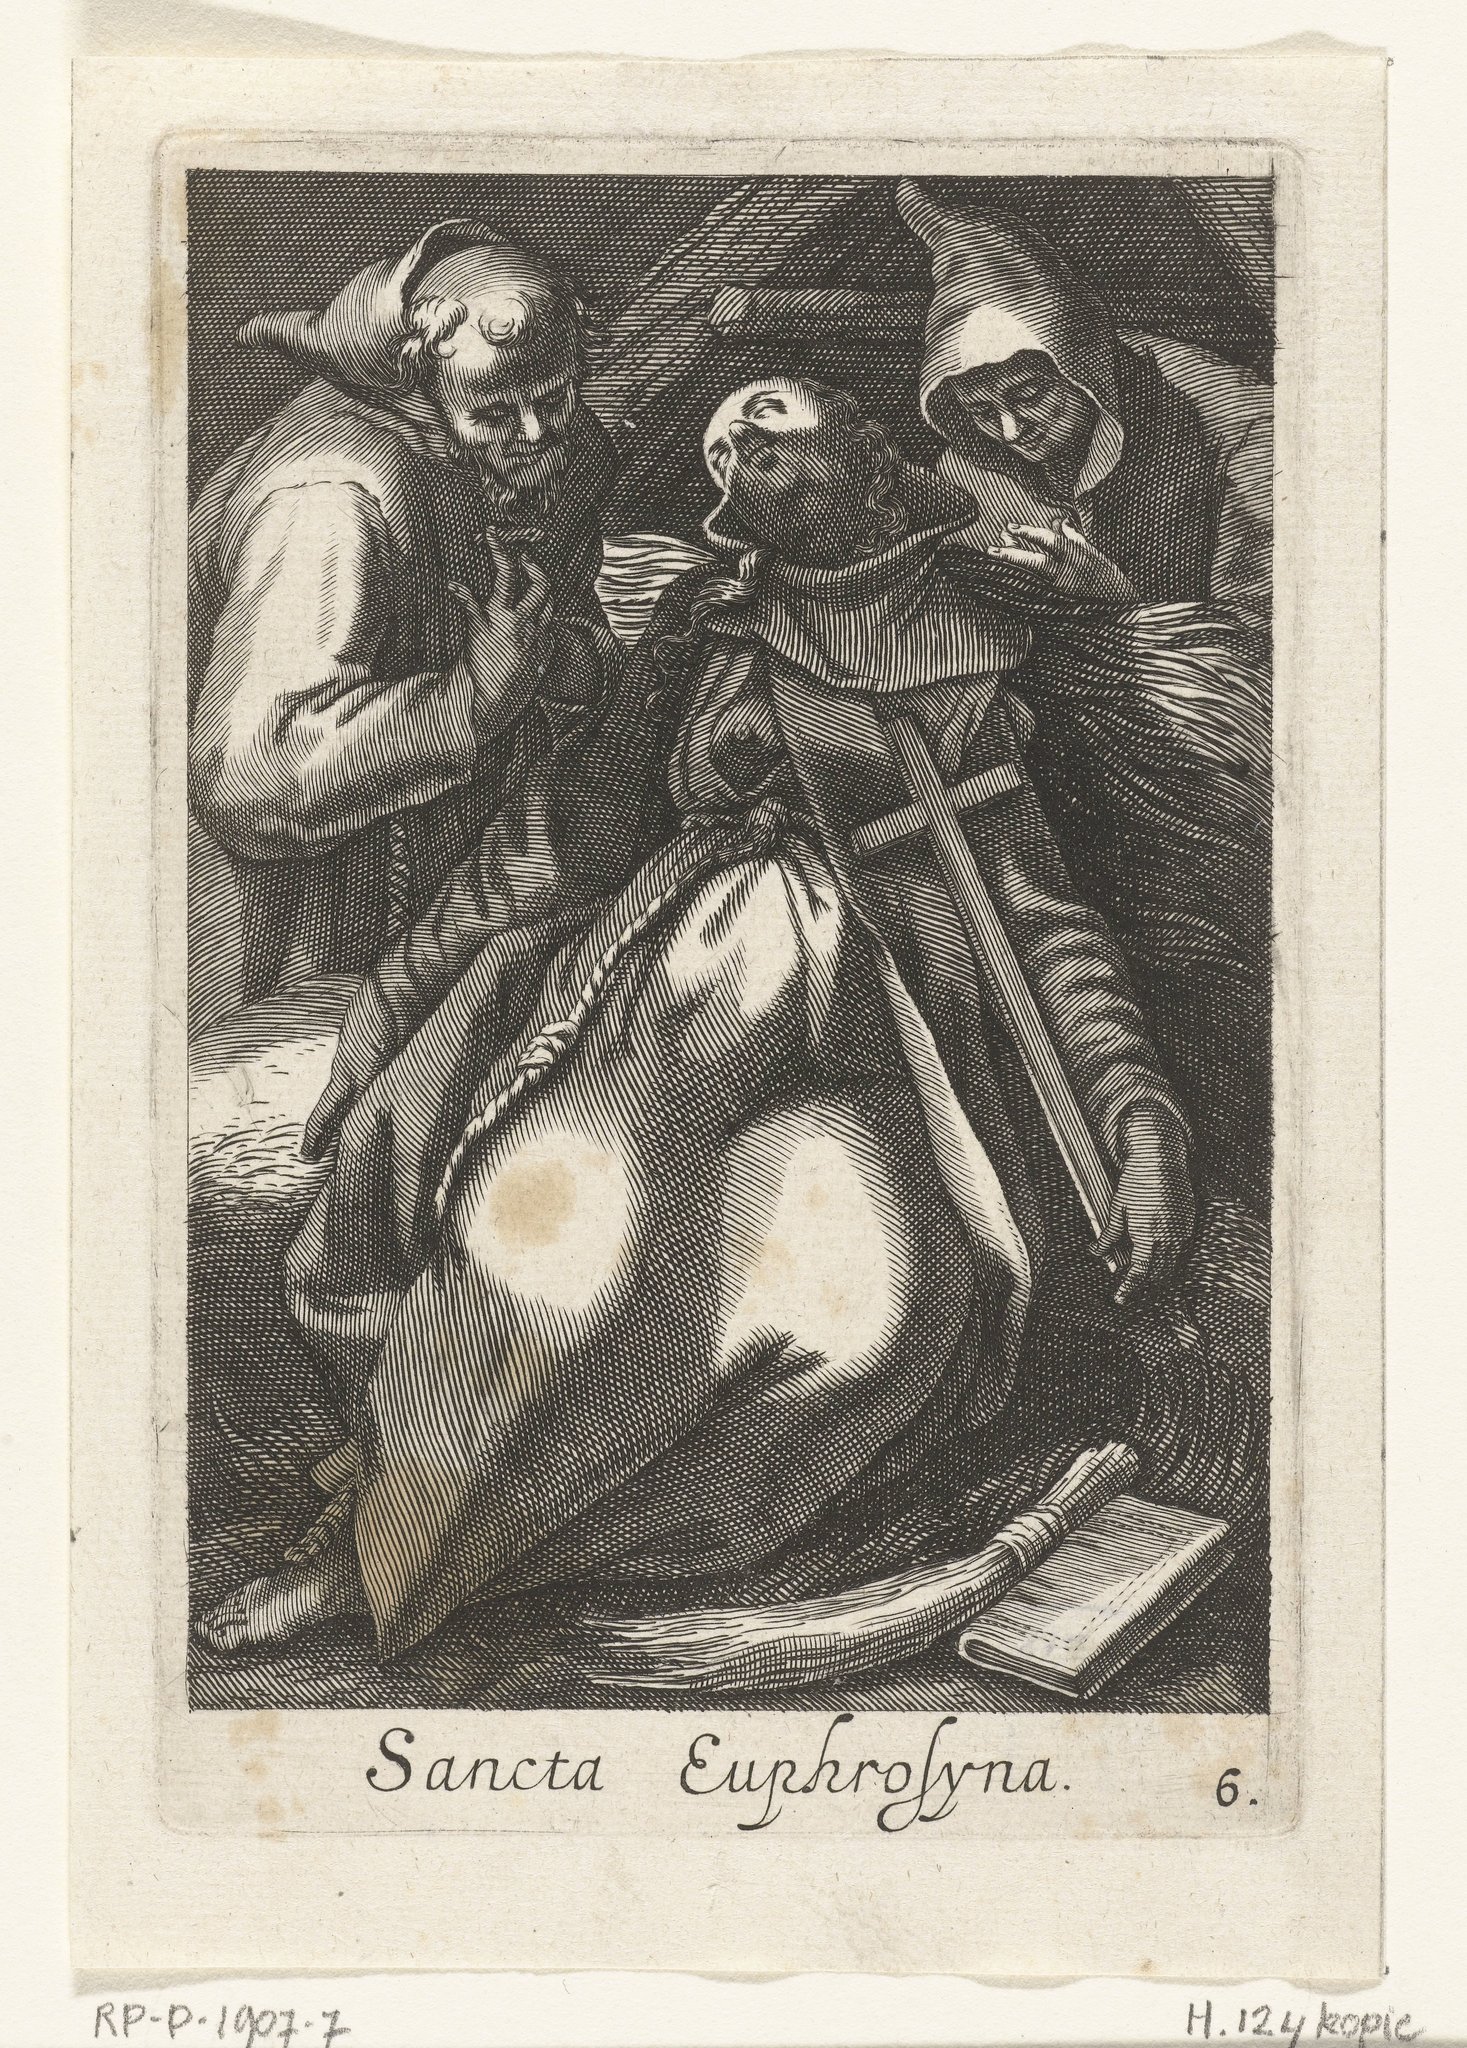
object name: print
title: Heilige Euphrosyna van Alexandrië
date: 1590-1662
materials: paper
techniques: engraving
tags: anchorite, hermit, female saints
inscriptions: collector's mark: Lugt 2228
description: Kopie in spiegelbeeld naar prent van Boëtius Adamsz. Bolswert uit serie Kluizenaressen.